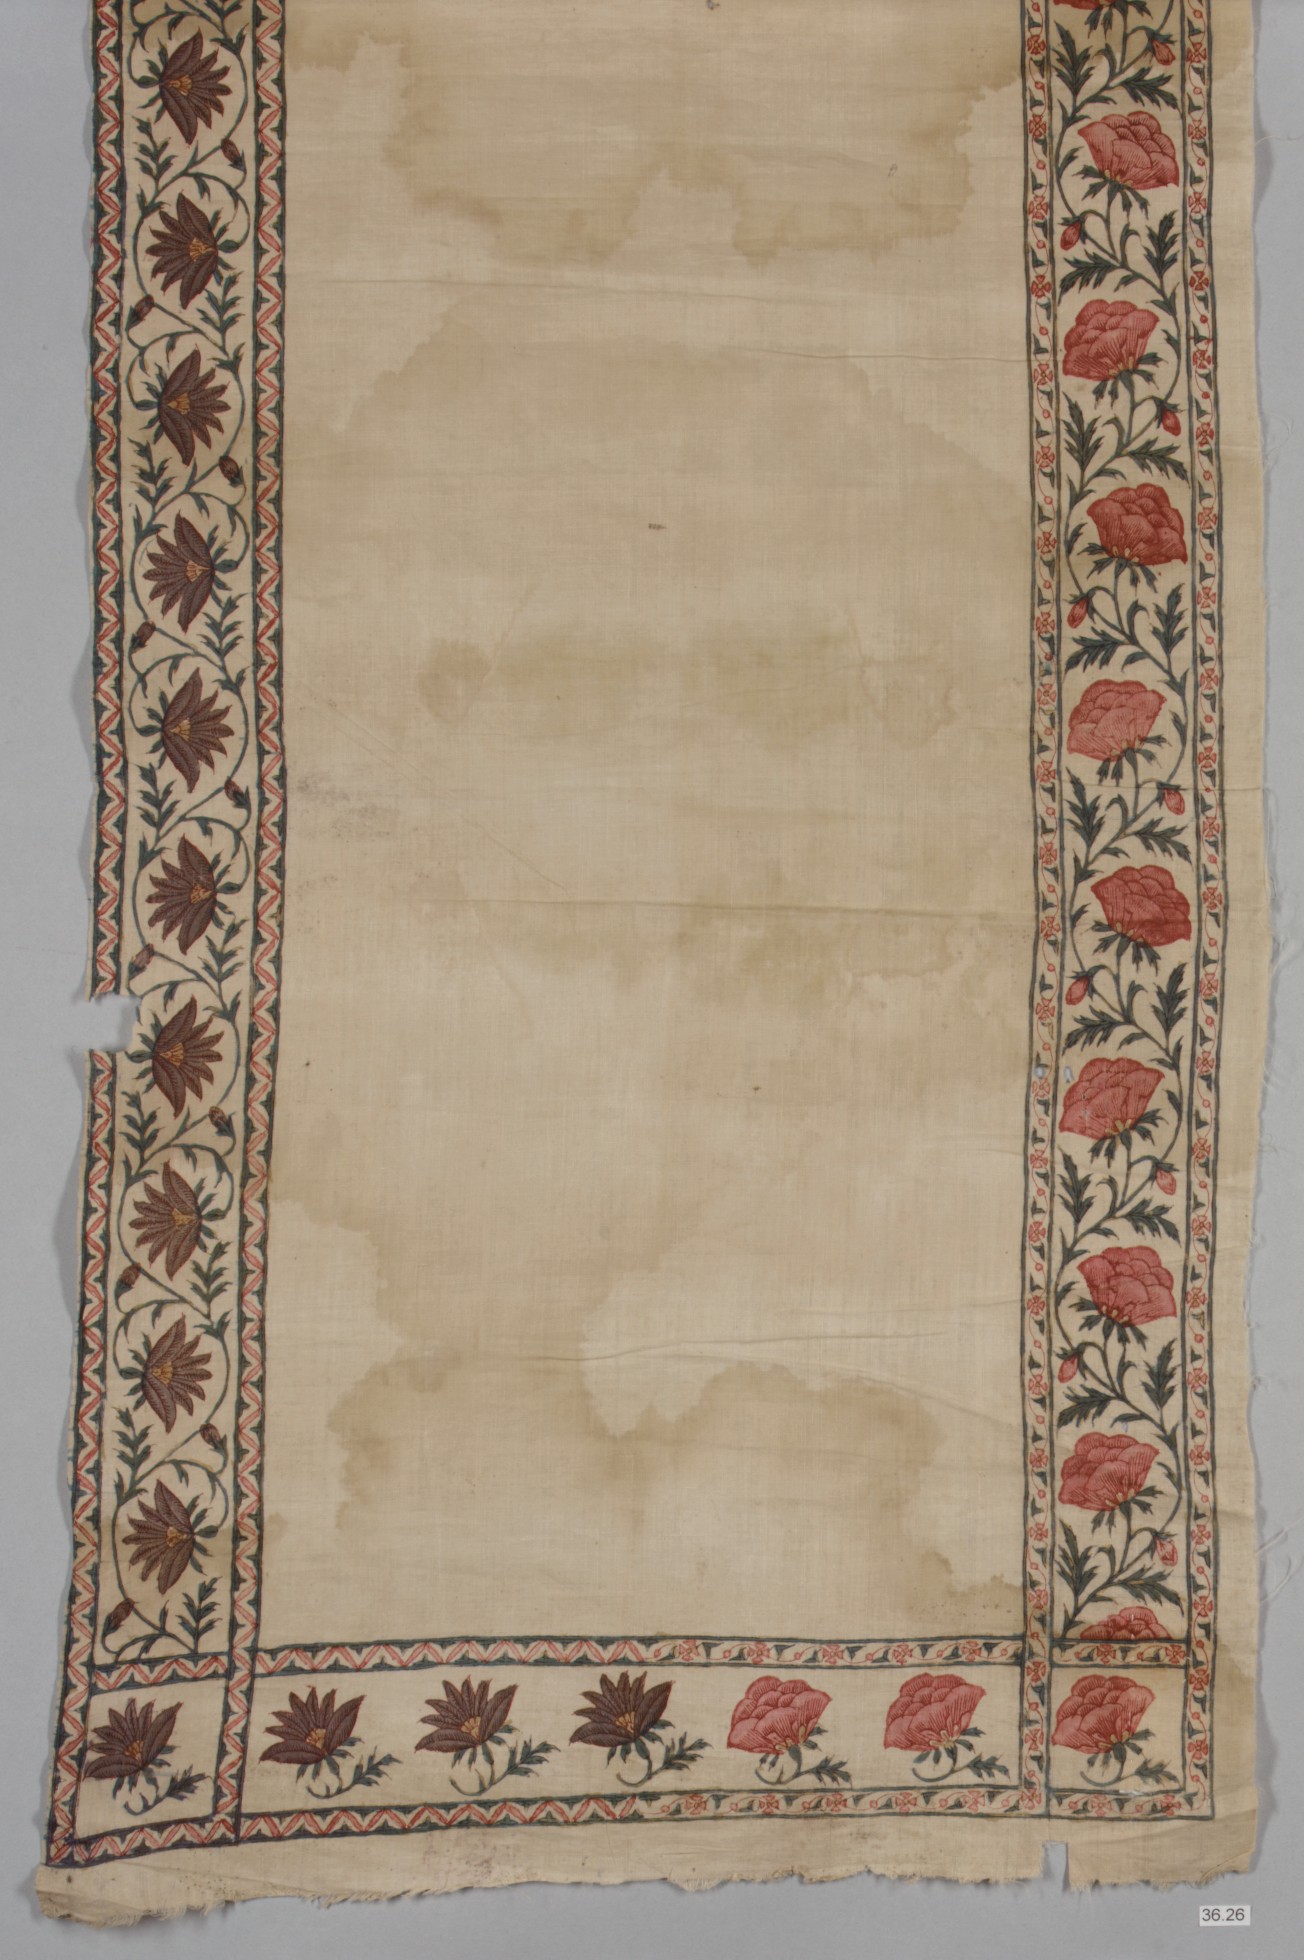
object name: sash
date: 1601-1700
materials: cotton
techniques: painting, printing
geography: india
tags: flowers